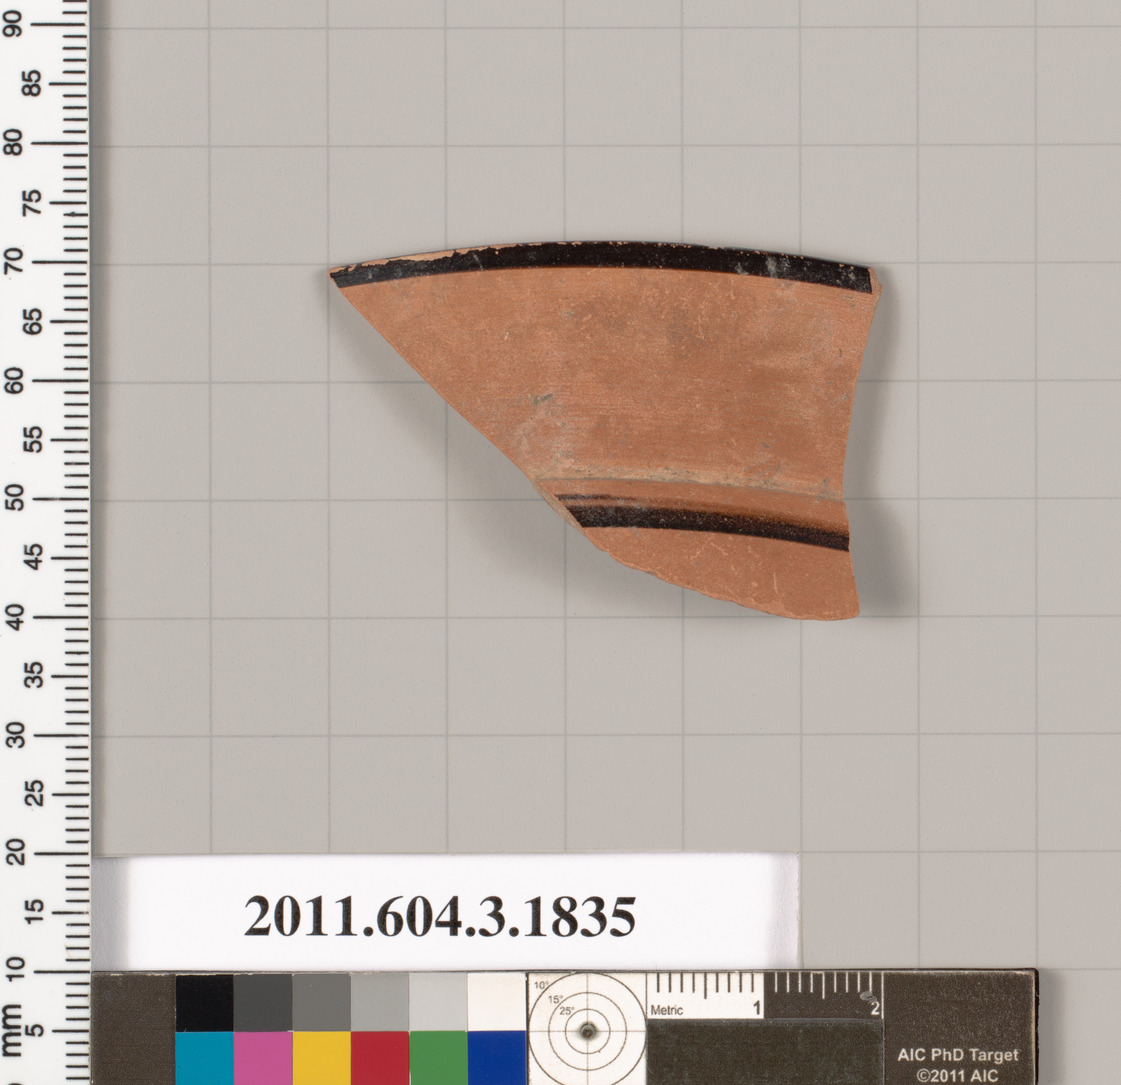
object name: kylix fragment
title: Terracotta fragment of a kylix: Lip cup (drinking cup)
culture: greek, attic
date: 560-525 BCE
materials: terracotta